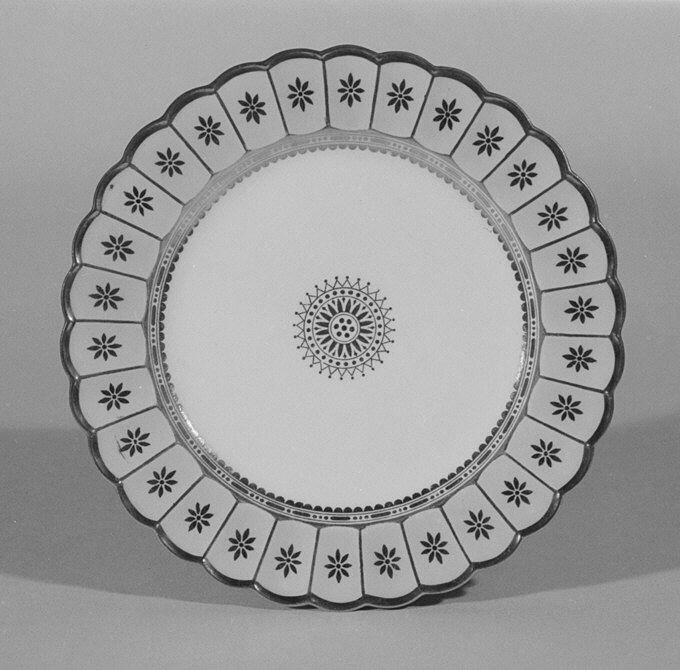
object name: ice cream plate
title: Ice cream plate (Patelle à glace cannelé)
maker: sèvres manufactory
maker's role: manufactory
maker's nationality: french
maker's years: 1740-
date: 1840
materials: hard paste porcelain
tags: flowers